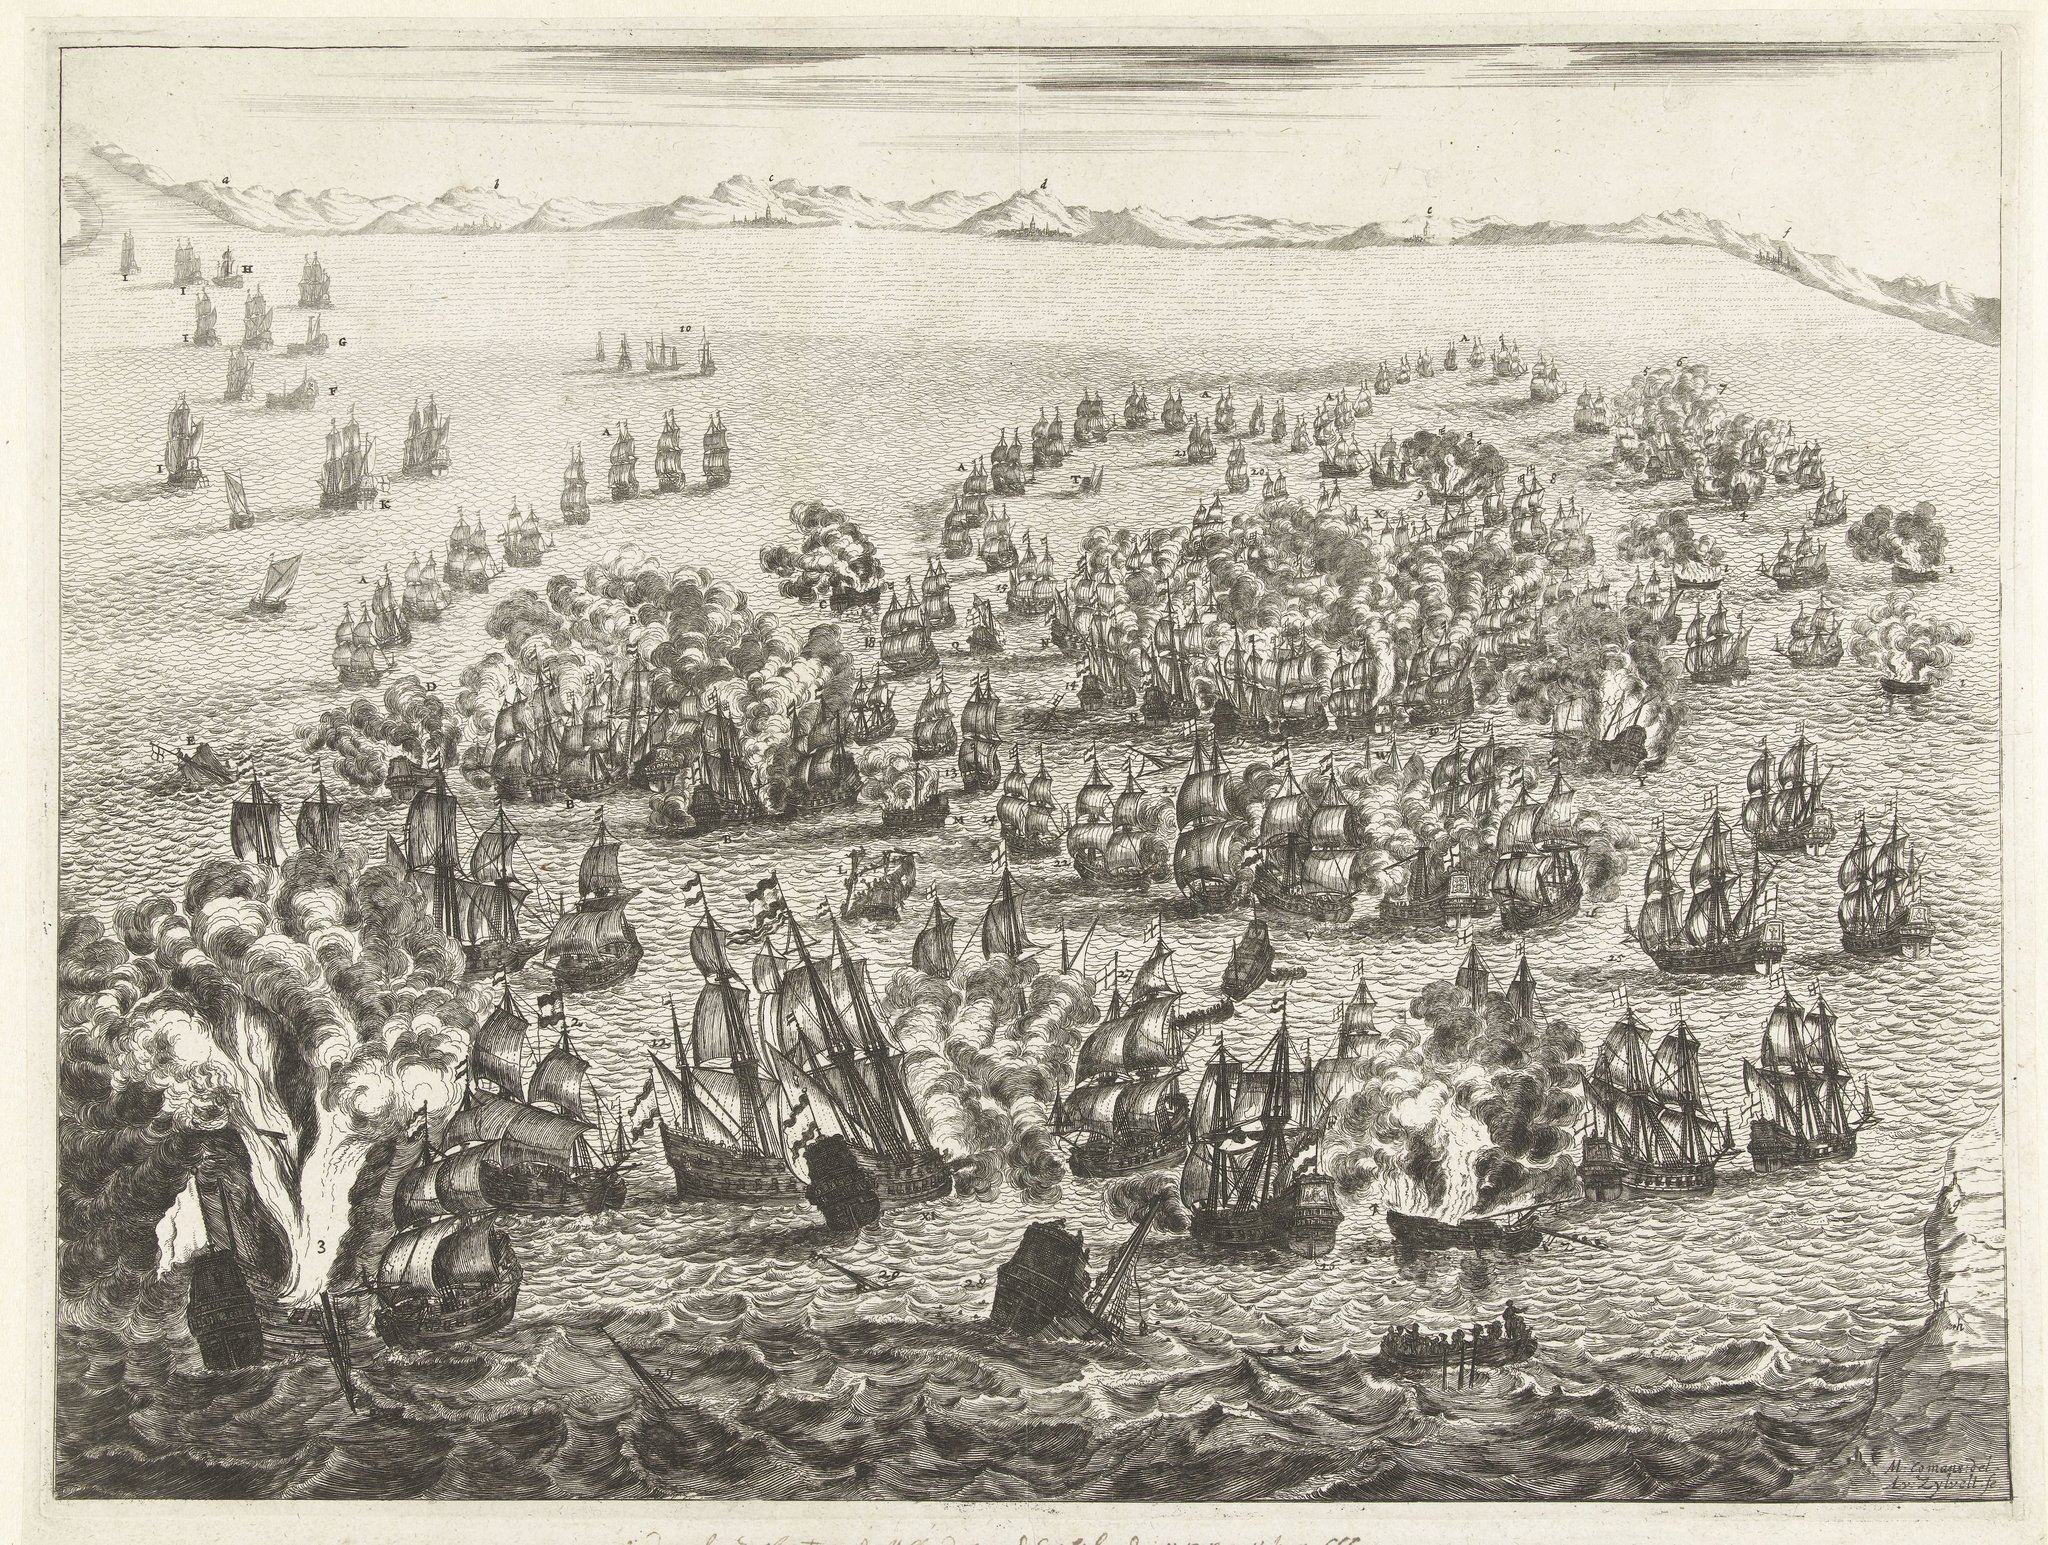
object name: print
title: Pertinente Afbeeldinge van de Victorieuse Vierdaeghsche Zeeslagh / bevochten door de Nederlantsche Vloot / tegens de Engelsche / op den 11 / 12 / 13 en 14 Junij 1666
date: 1666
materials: paper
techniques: etching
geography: northern netherlands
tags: flushing, michiel adriaenszoon de ruyter, battle (+ naval force)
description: De Vierdaagse Zeeslag tussen de Staatse vloot onder admiraal Michiel Adriaenszoon de Ruyter en de Engelse vloot onder admiraal George Monck, 11-14 juni 1666. Op de achtergrond de Vlaamse kust. Bij de prent behoort een tekstblad.